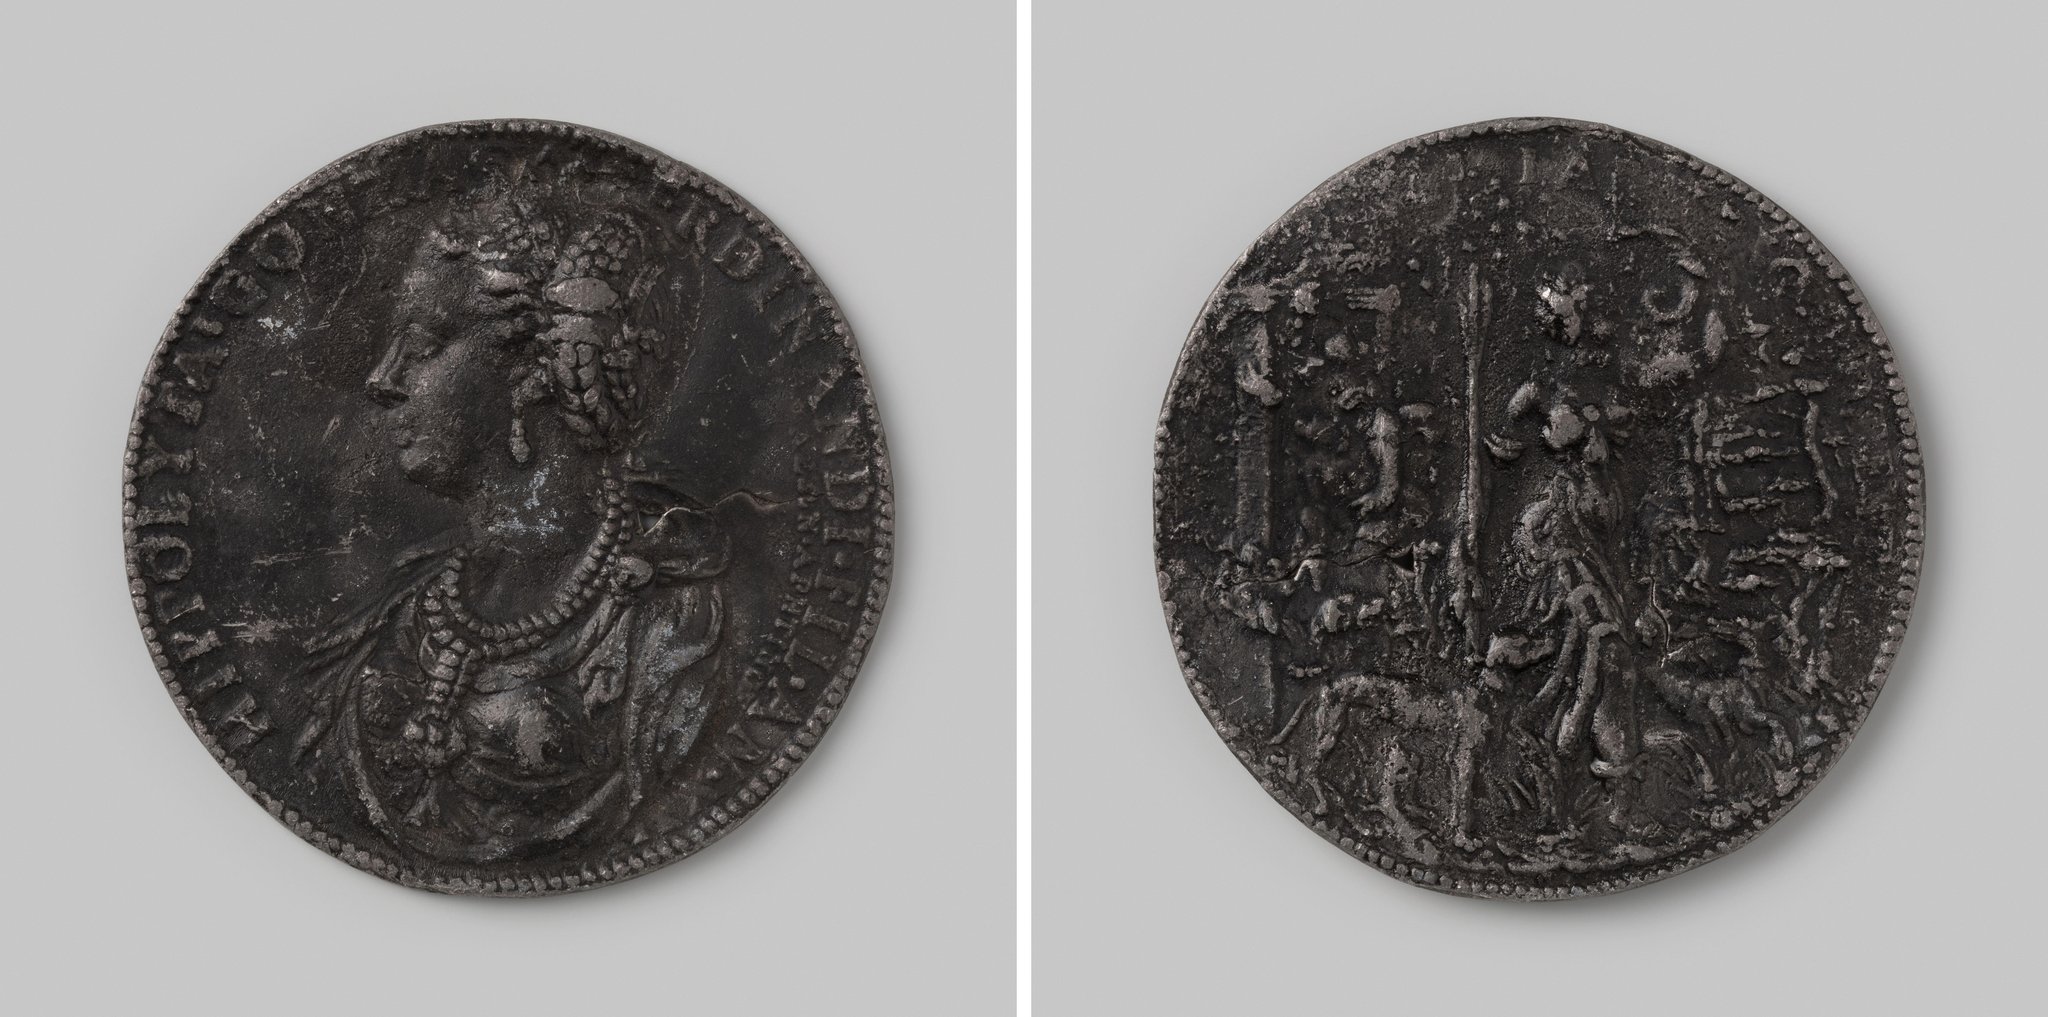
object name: history medal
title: Ippolyta van Gonzaga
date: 1551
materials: tin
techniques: casting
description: Zwart gelakte tinnen penning, op de vfoorzijde het borstbeeld van Ippolyta naar links met omschrift, op de keerzijde Diana met honden op jacht.